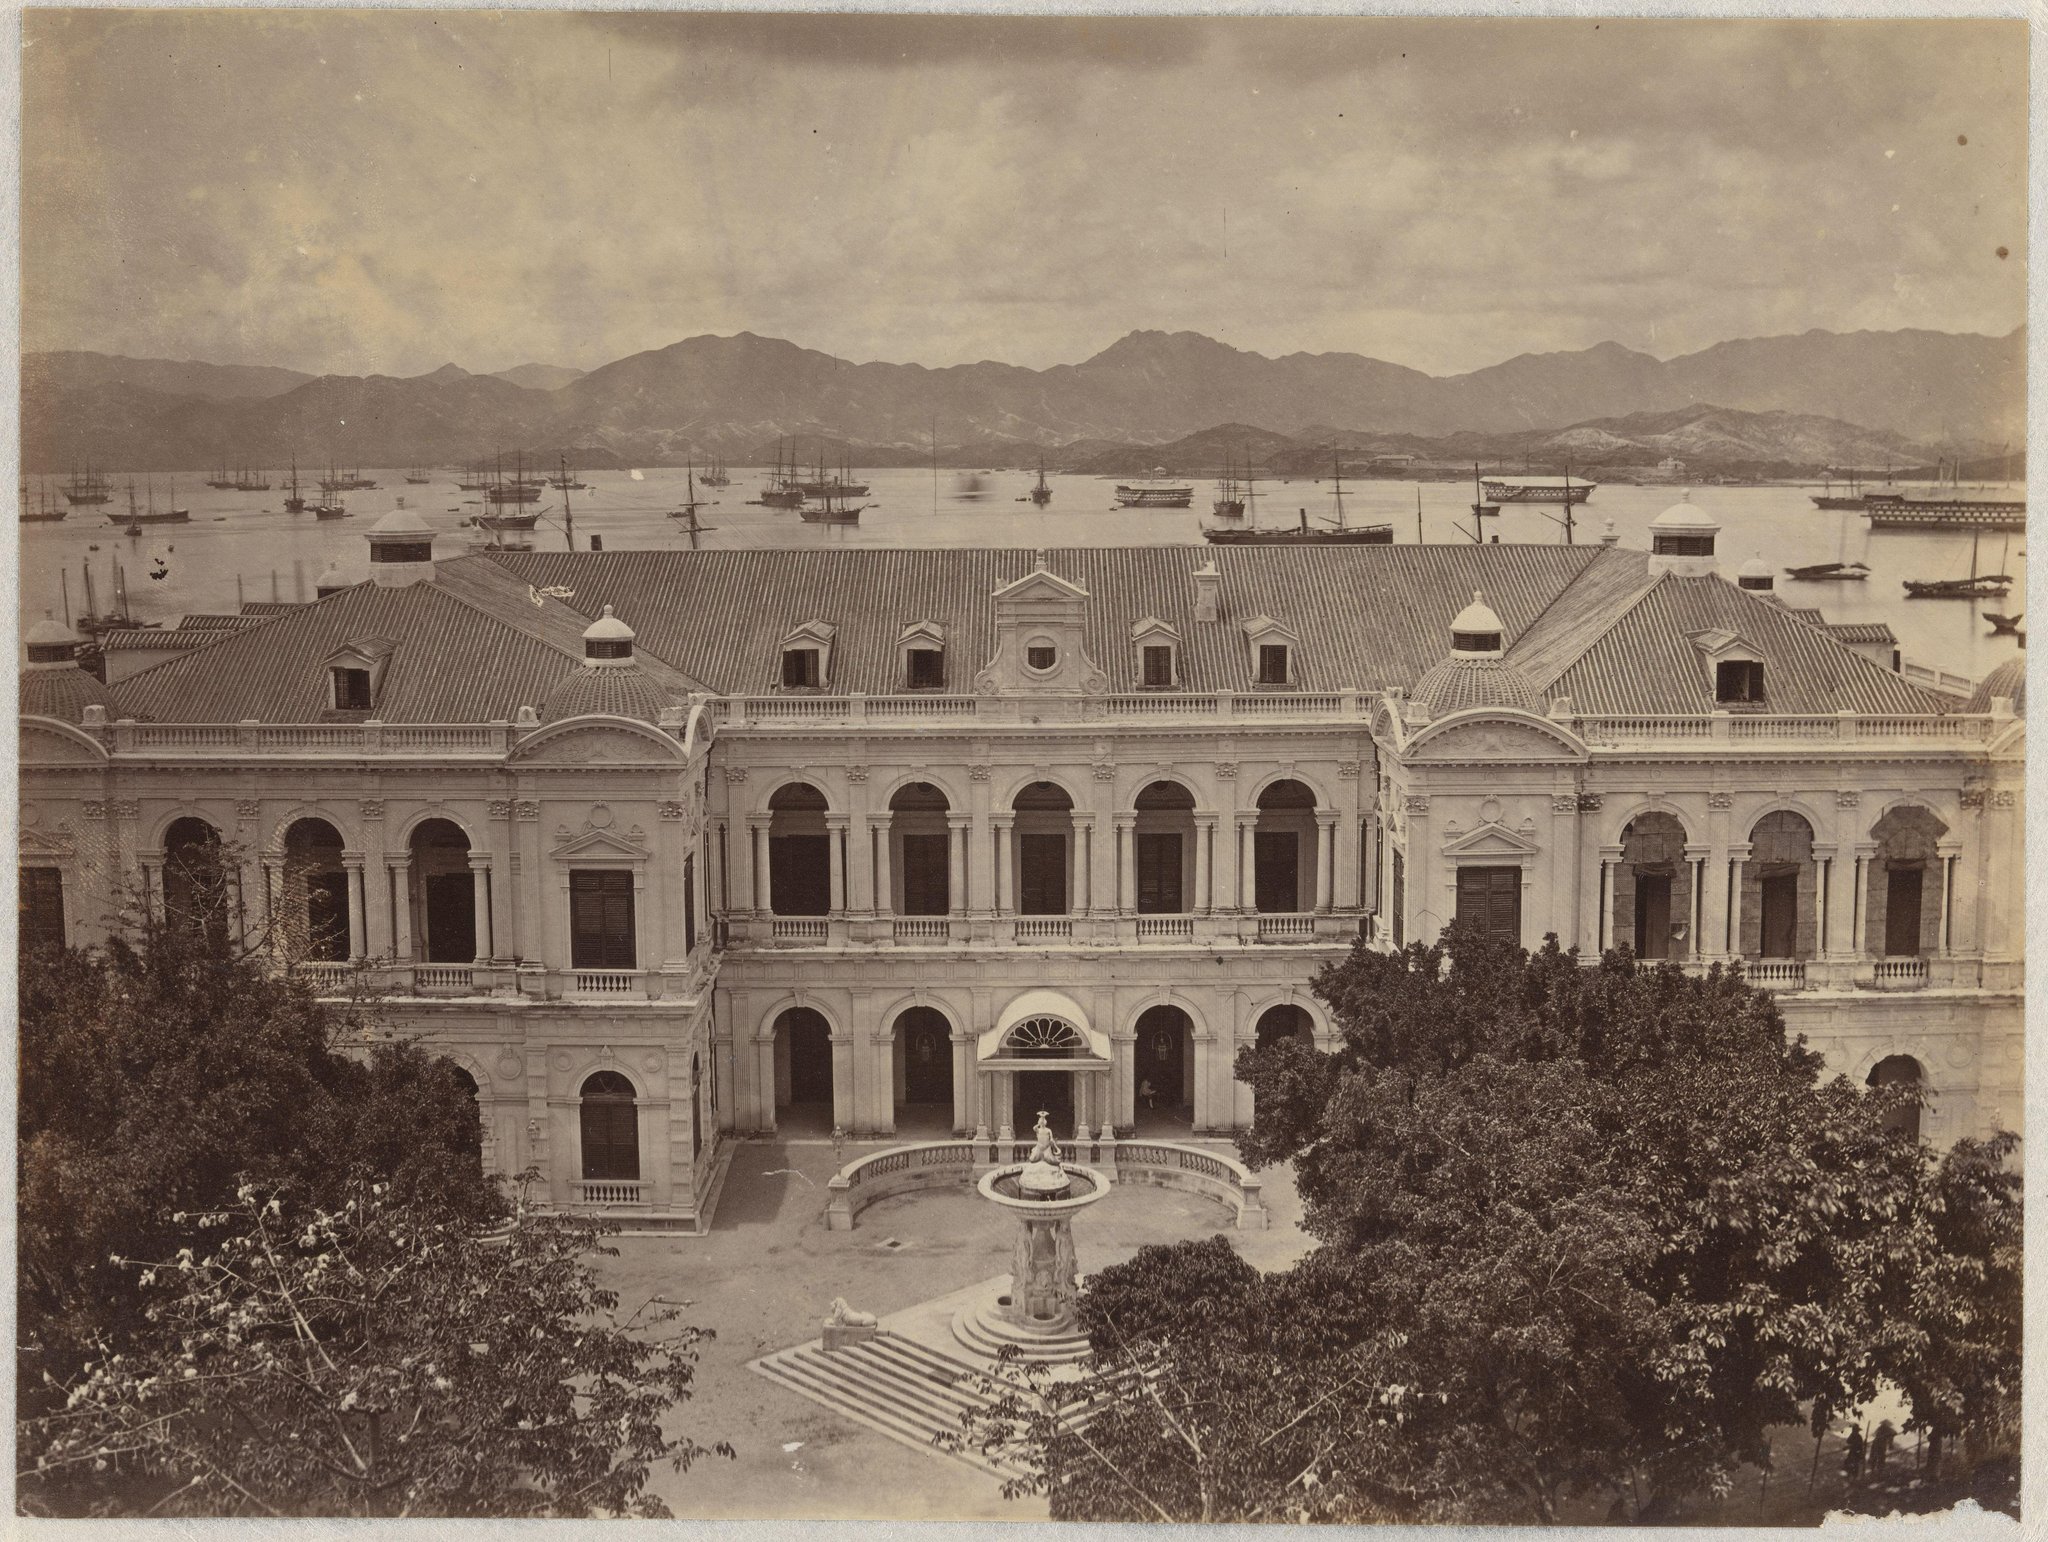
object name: photograph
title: Niko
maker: Anonymous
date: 1865-1870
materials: paper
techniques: albumen print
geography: japan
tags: japan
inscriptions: number: ‘E2’, number: ‘2’